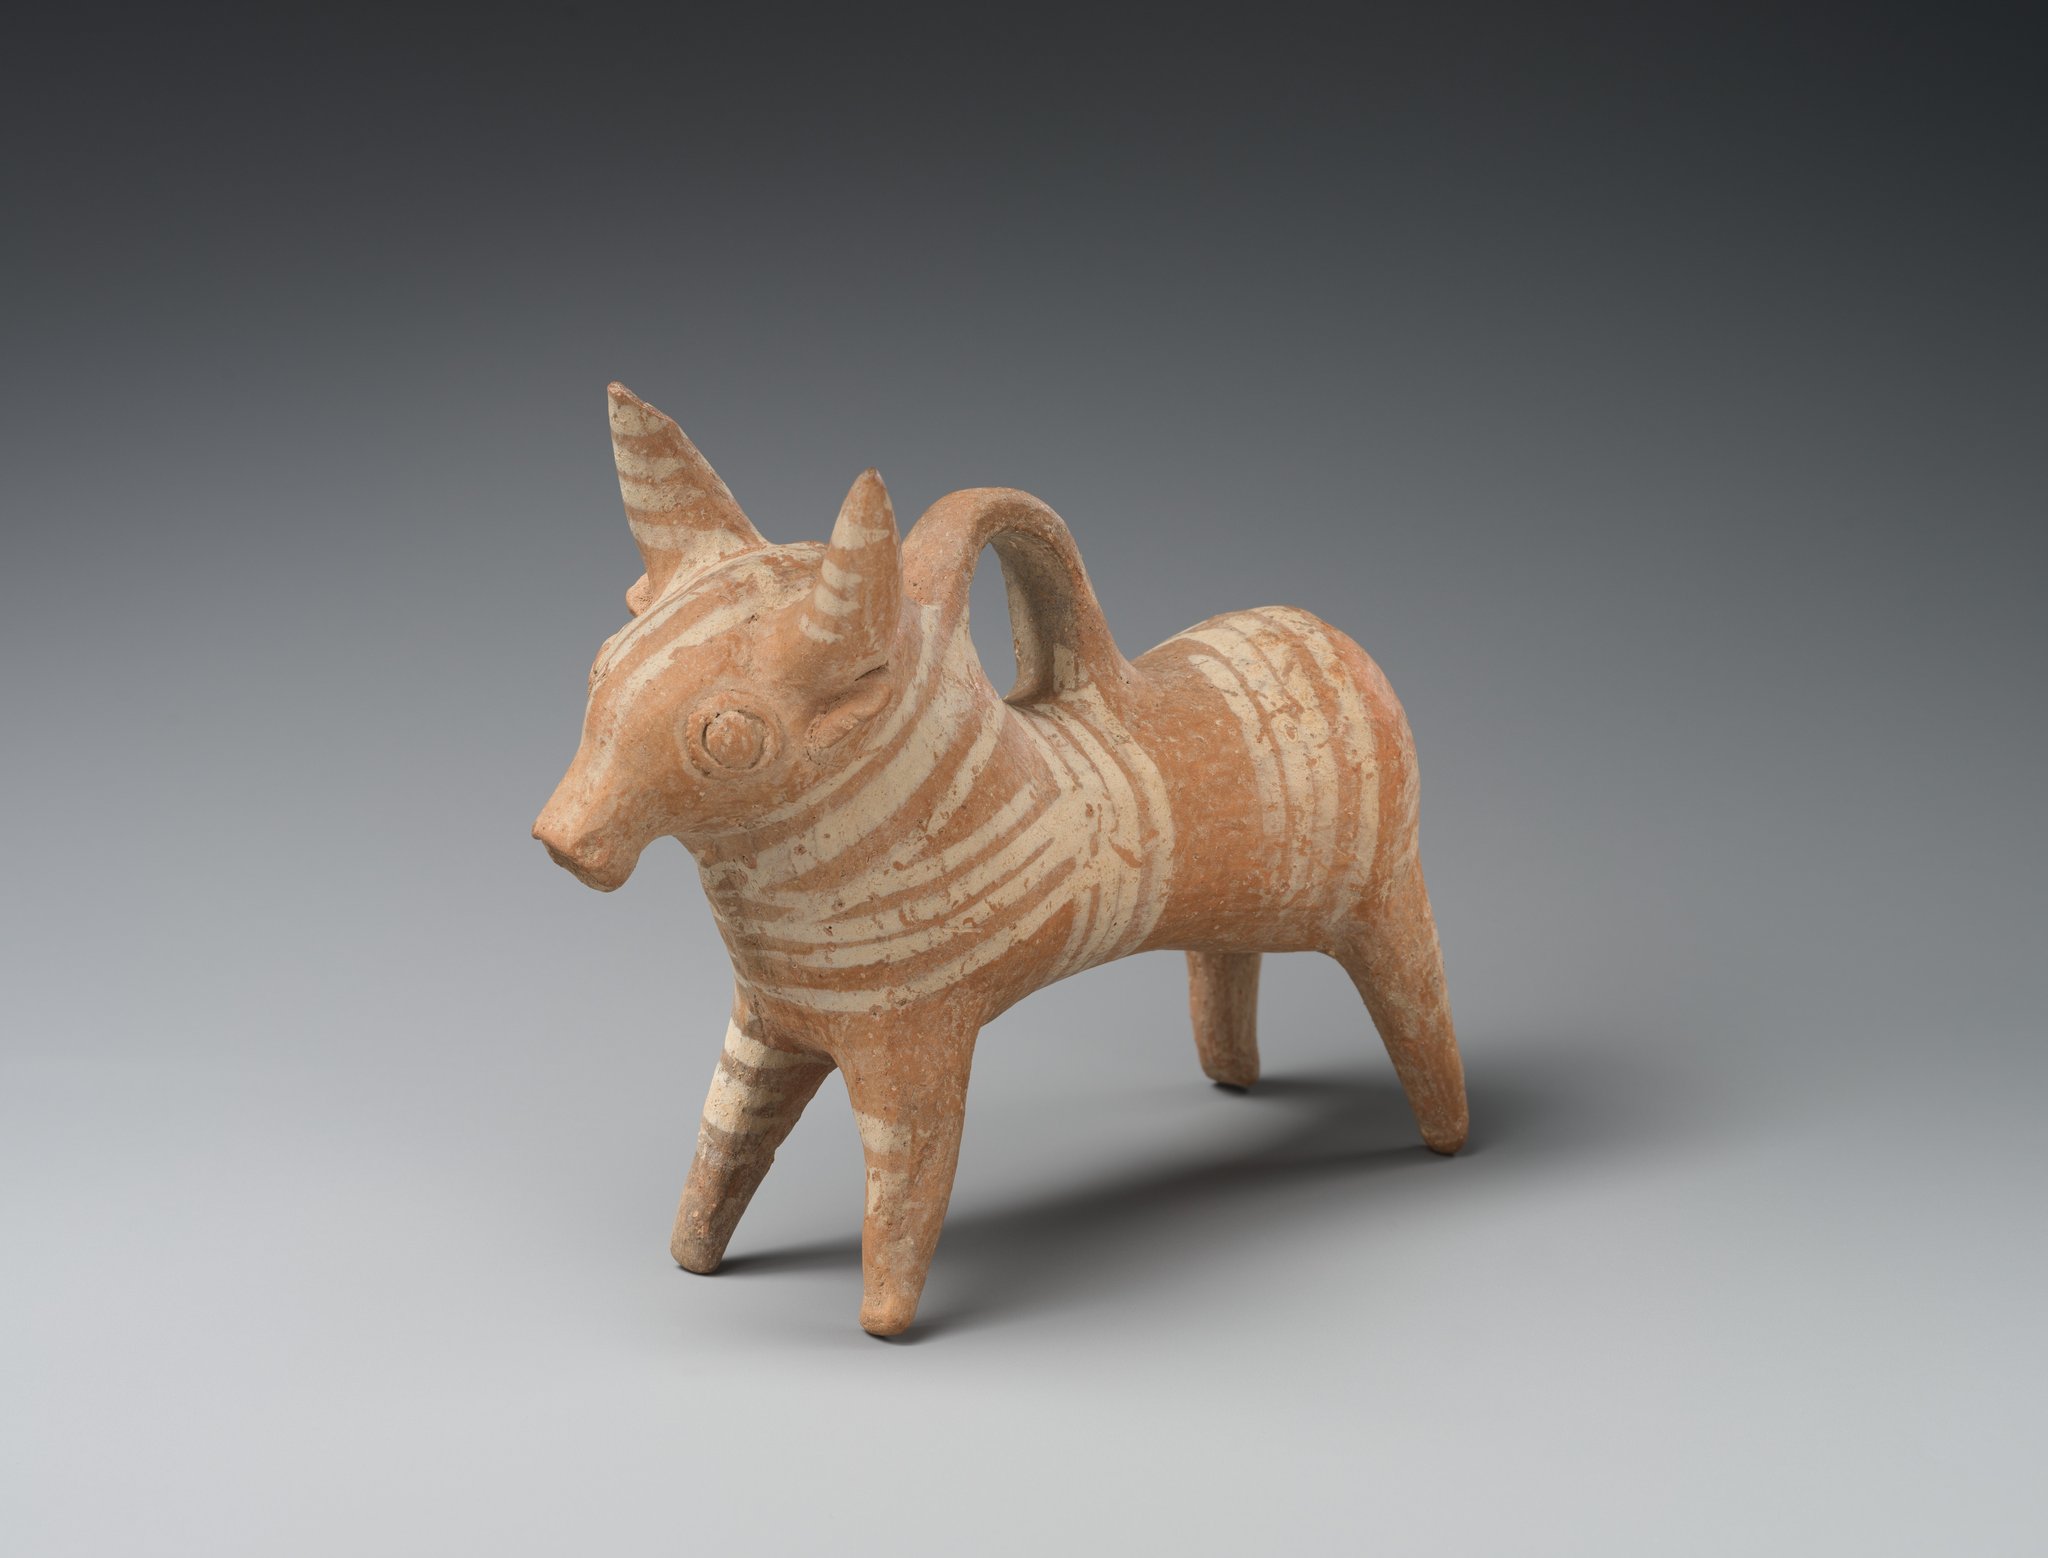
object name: vase in the form of a bull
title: Terracotta vase in the form of a bull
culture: cypriot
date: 1450-1200 BCE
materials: terracotta